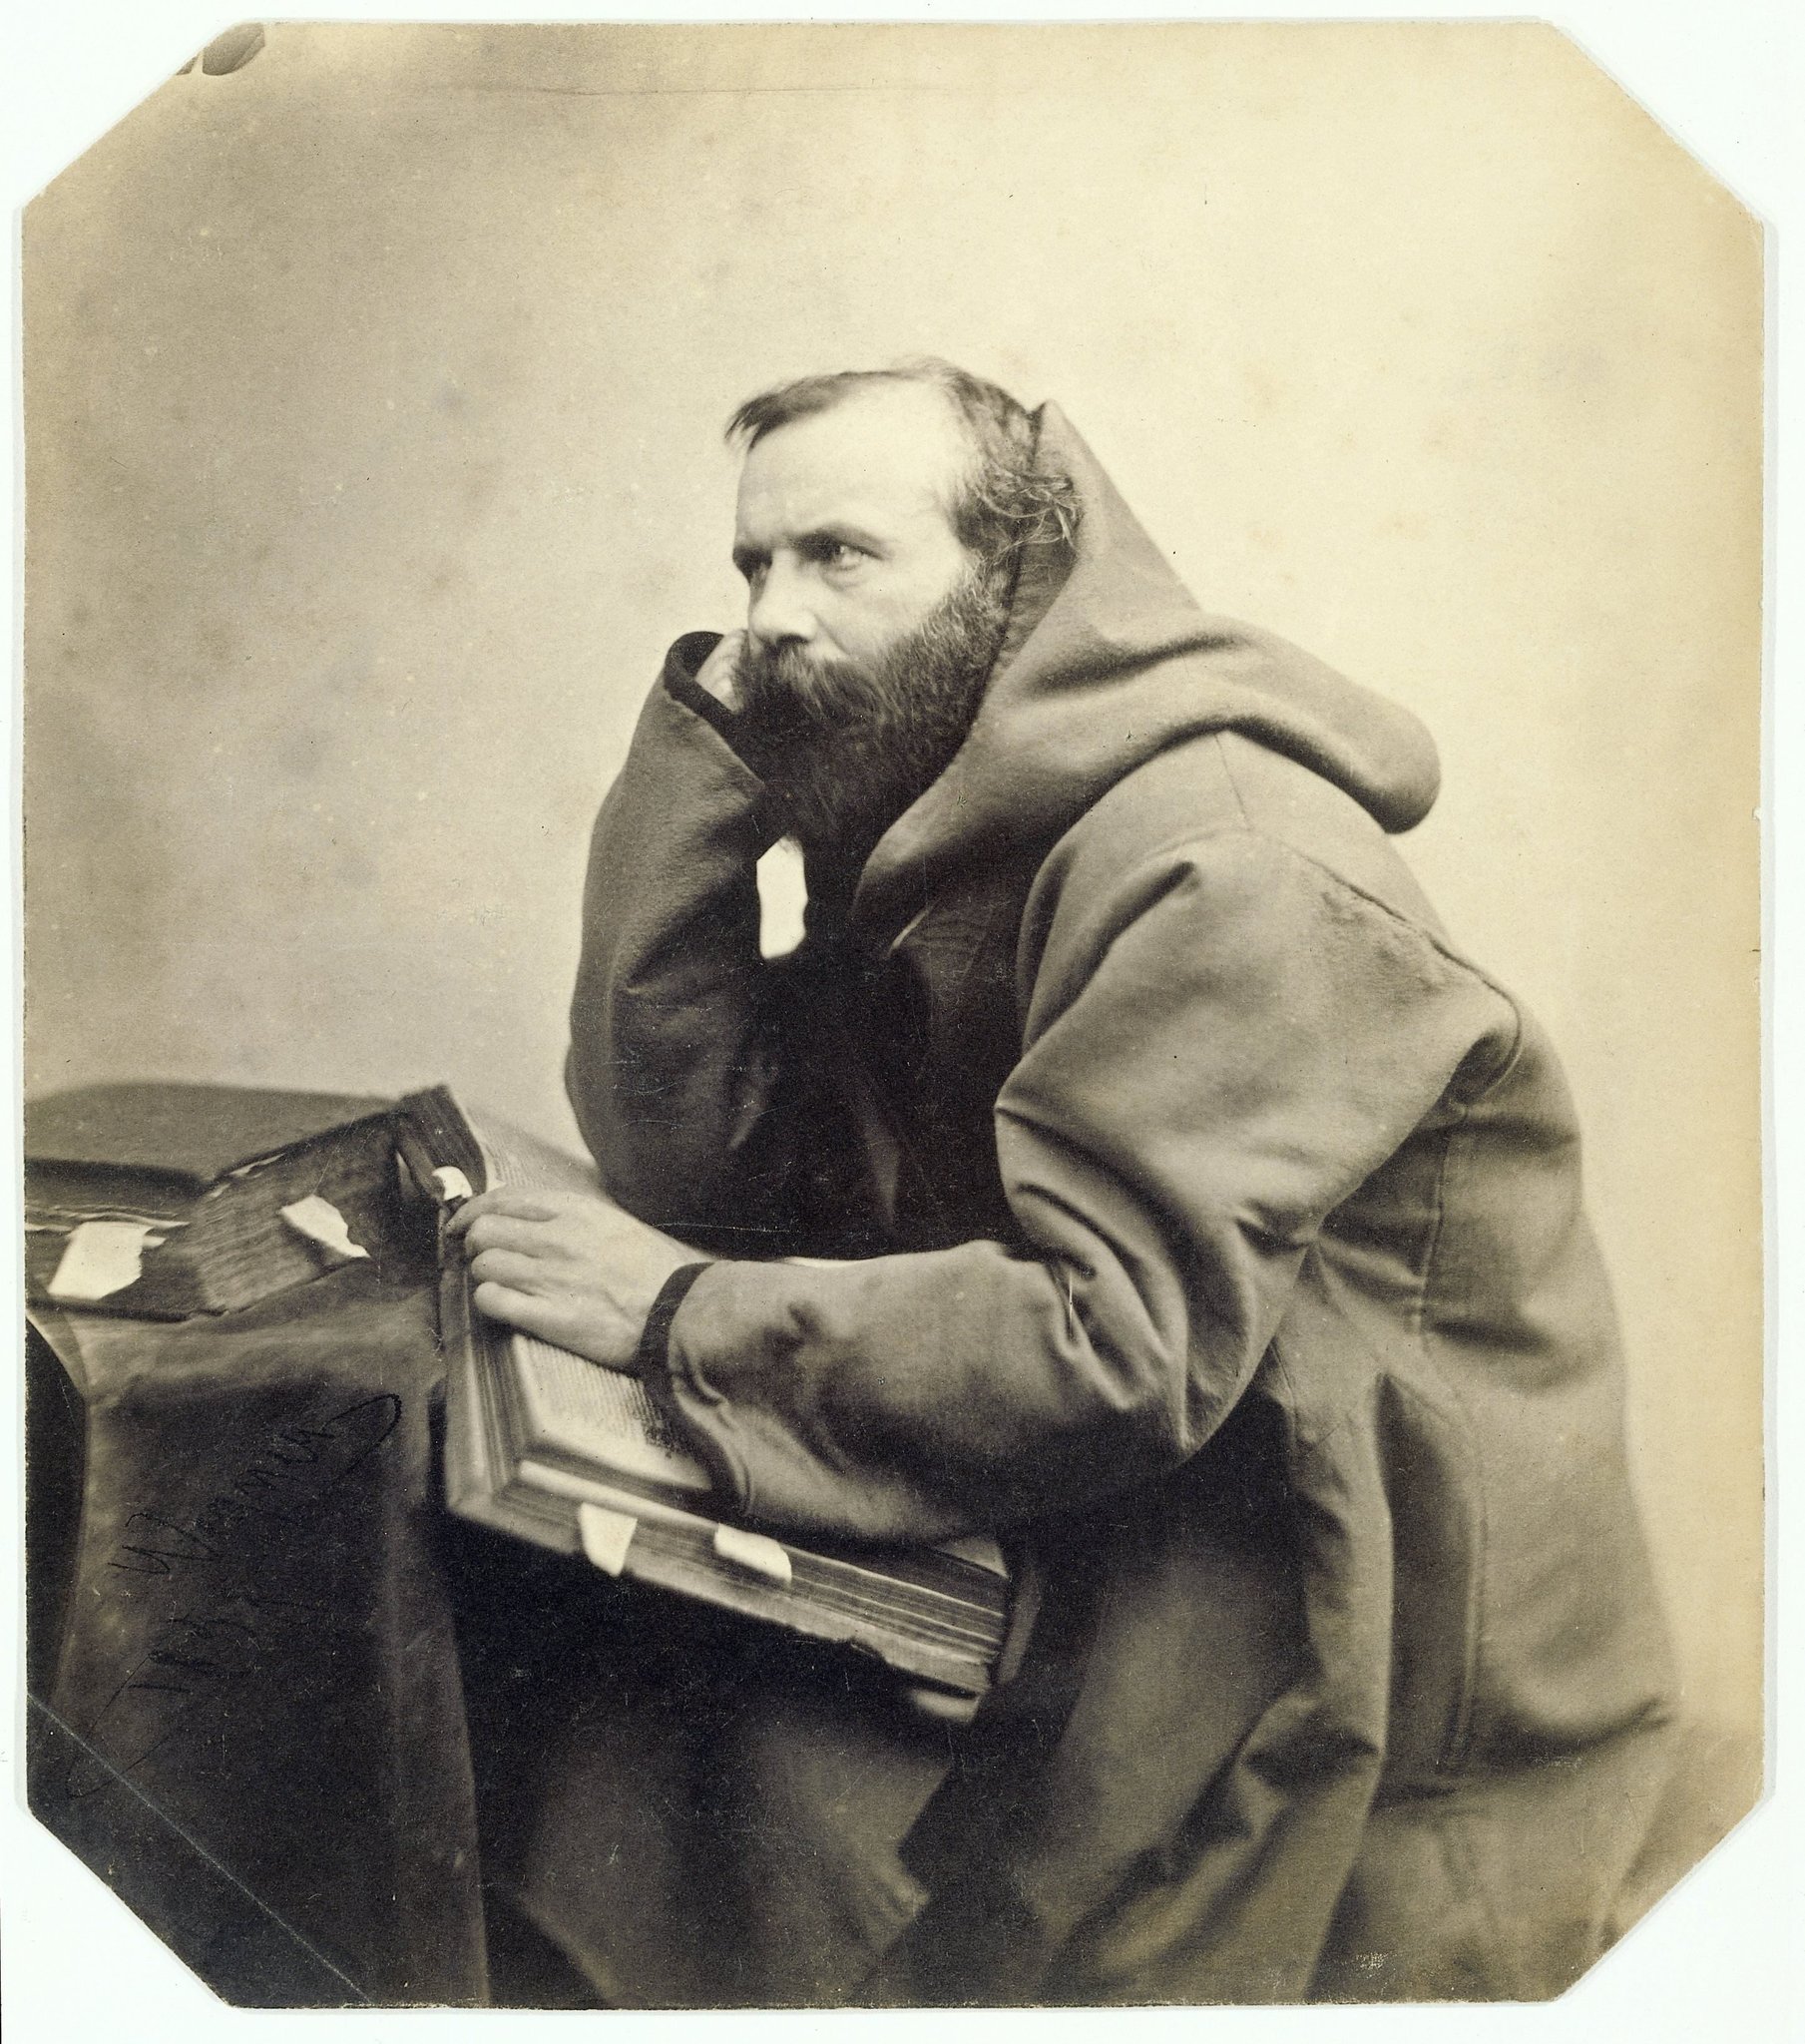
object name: photograph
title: Genreportret van een monnik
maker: louis wegner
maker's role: print maker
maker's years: 1816-1864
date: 1858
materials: cardboard, paper, photographic support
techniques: salted paper print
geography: amsterdam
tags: monk(s), friar(s), netherlands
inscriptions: signature and date: ‘Wegner / 1858’